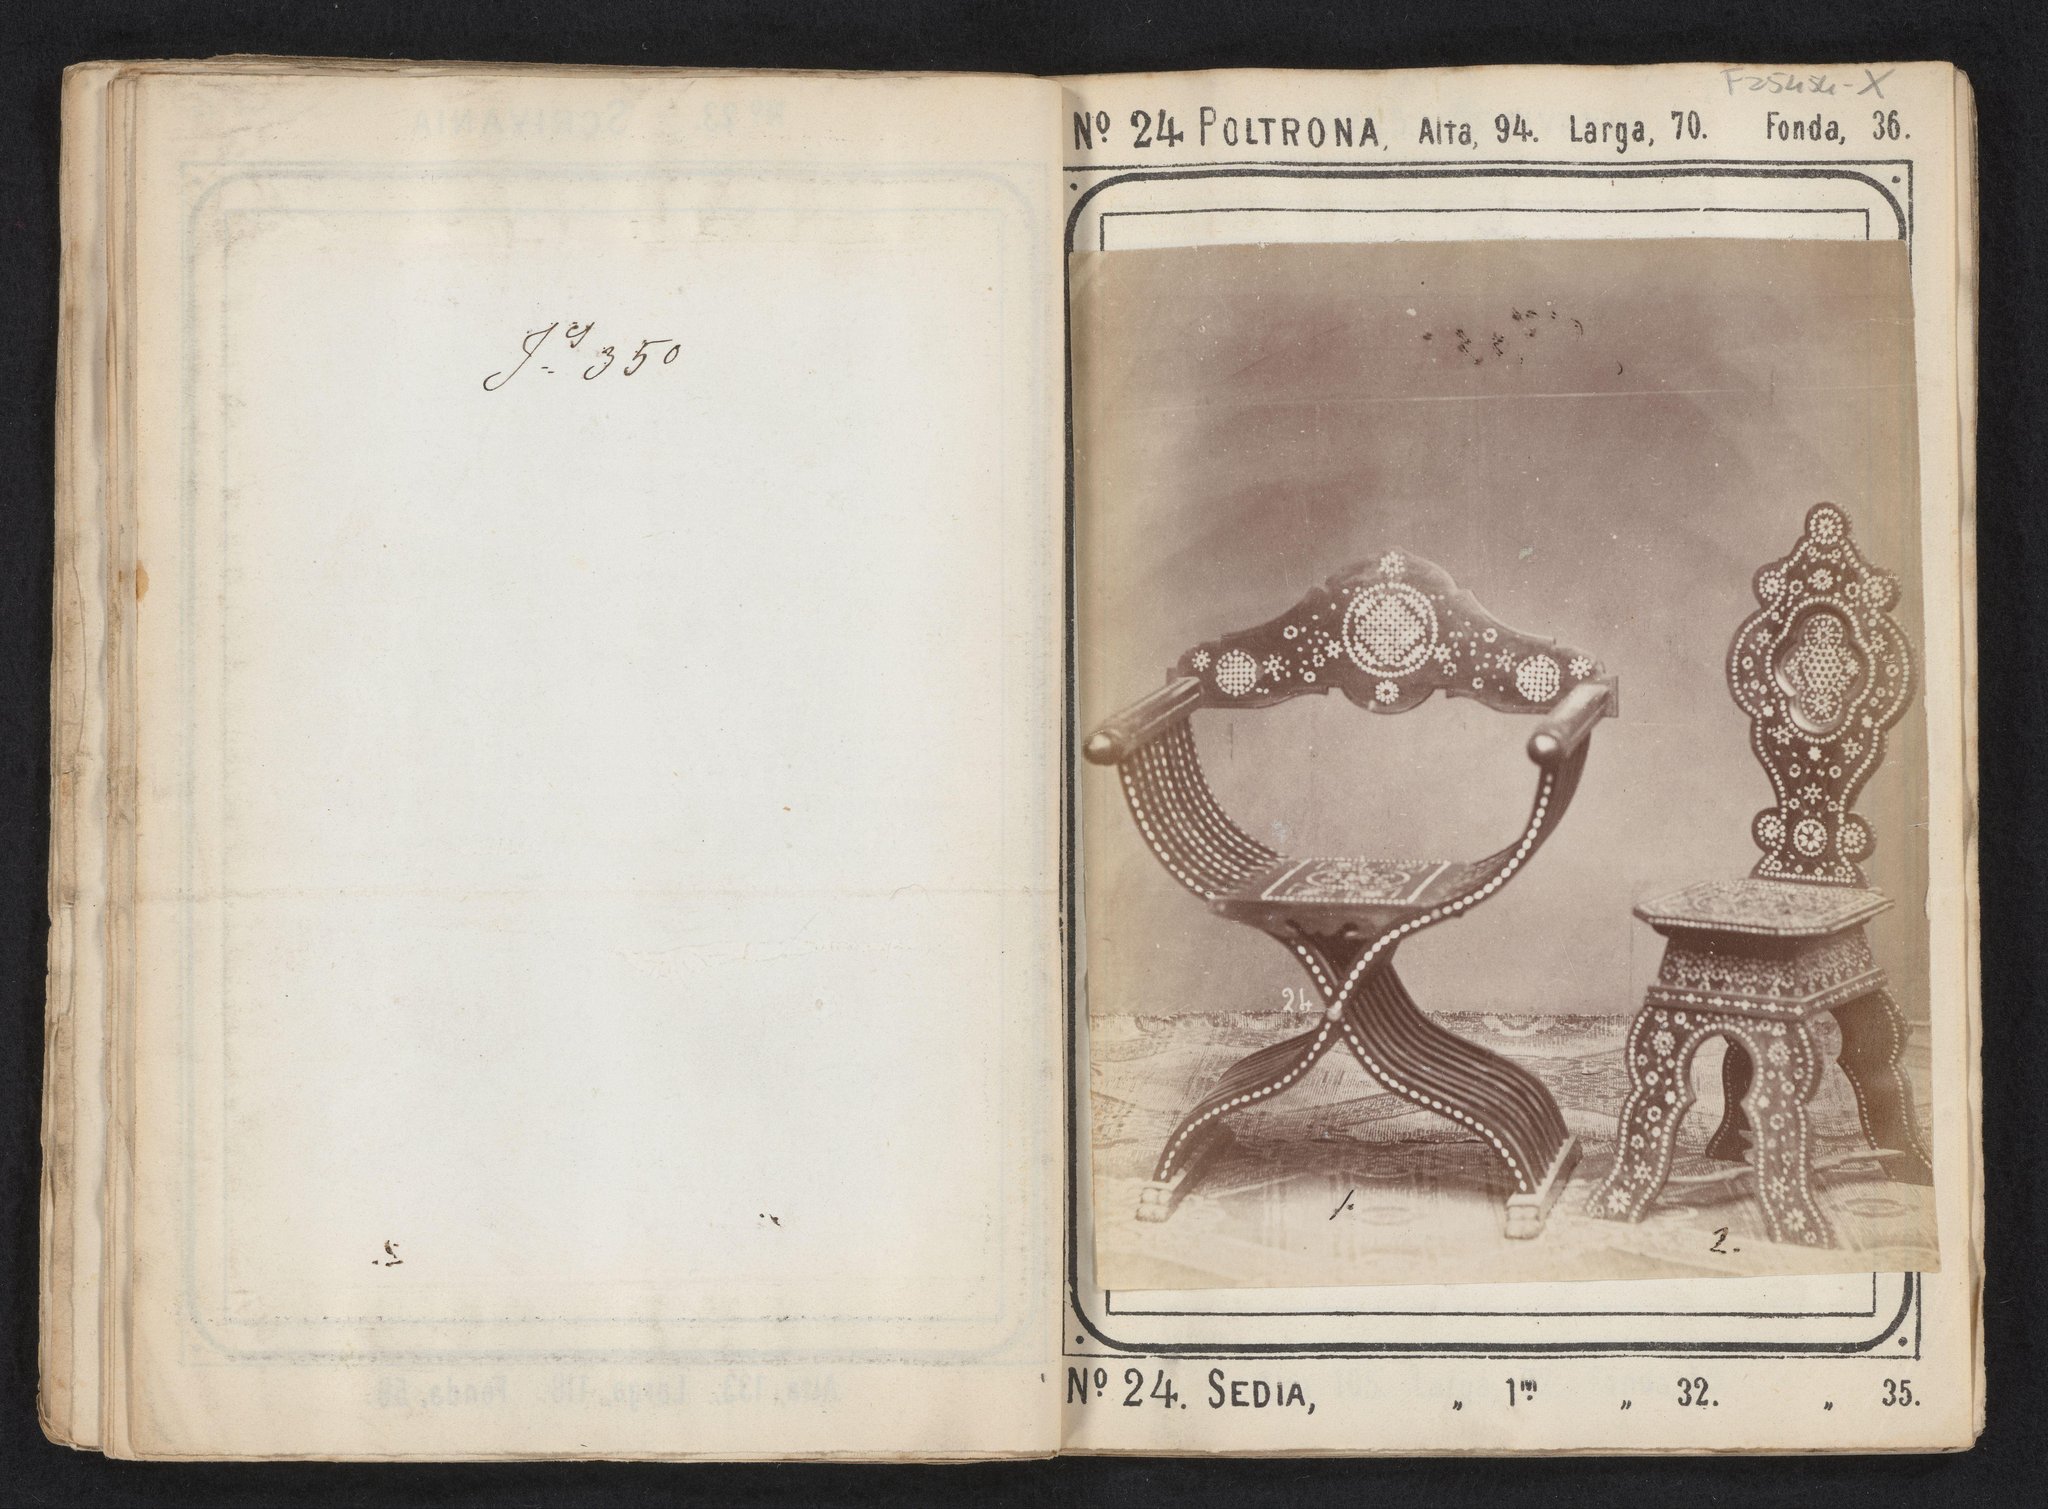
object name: page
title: No 24 Poltrona, Sedia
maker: Anonymous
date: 1878-1885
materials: paper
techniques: albumen print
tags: chair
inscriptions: number: ‘1. 2.’, inscription: ‘No 1. Ies. 60./ " 2. 45’, inscription: ‘Alta, 94. Larga, 70. Fonda, 36./ " 1m. " 32. " 35.’